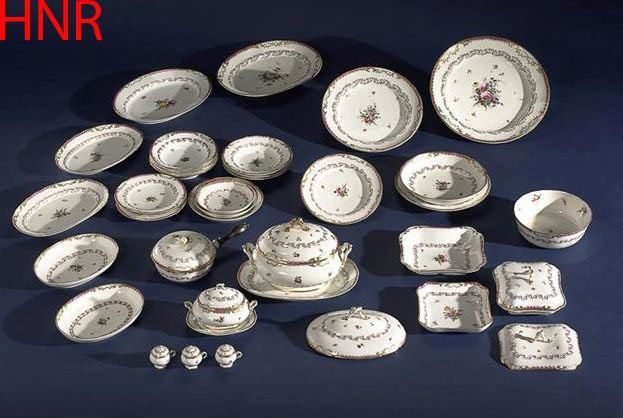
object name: plate dish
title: Bord, diep model, behorend bij een servies met geslingerd lintmotief met bladertakken, bloemboeketten en gestrooide bloemtakken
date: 1780-1820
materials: porcelain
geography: loosdrecht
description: Bord, diep model, behorend bij een servies van porselein met geslingerd lintmotief in paars en goud met groene bladertakken, bloemboeketten en gestrooide bloemtakken. Randen lichtgegolfd met decoratie in goud met paars bladmotief waartussen groen gekruist bladmotief. Gemerkt: M.O.L. en Amstel. Serie van vijftien stuks.